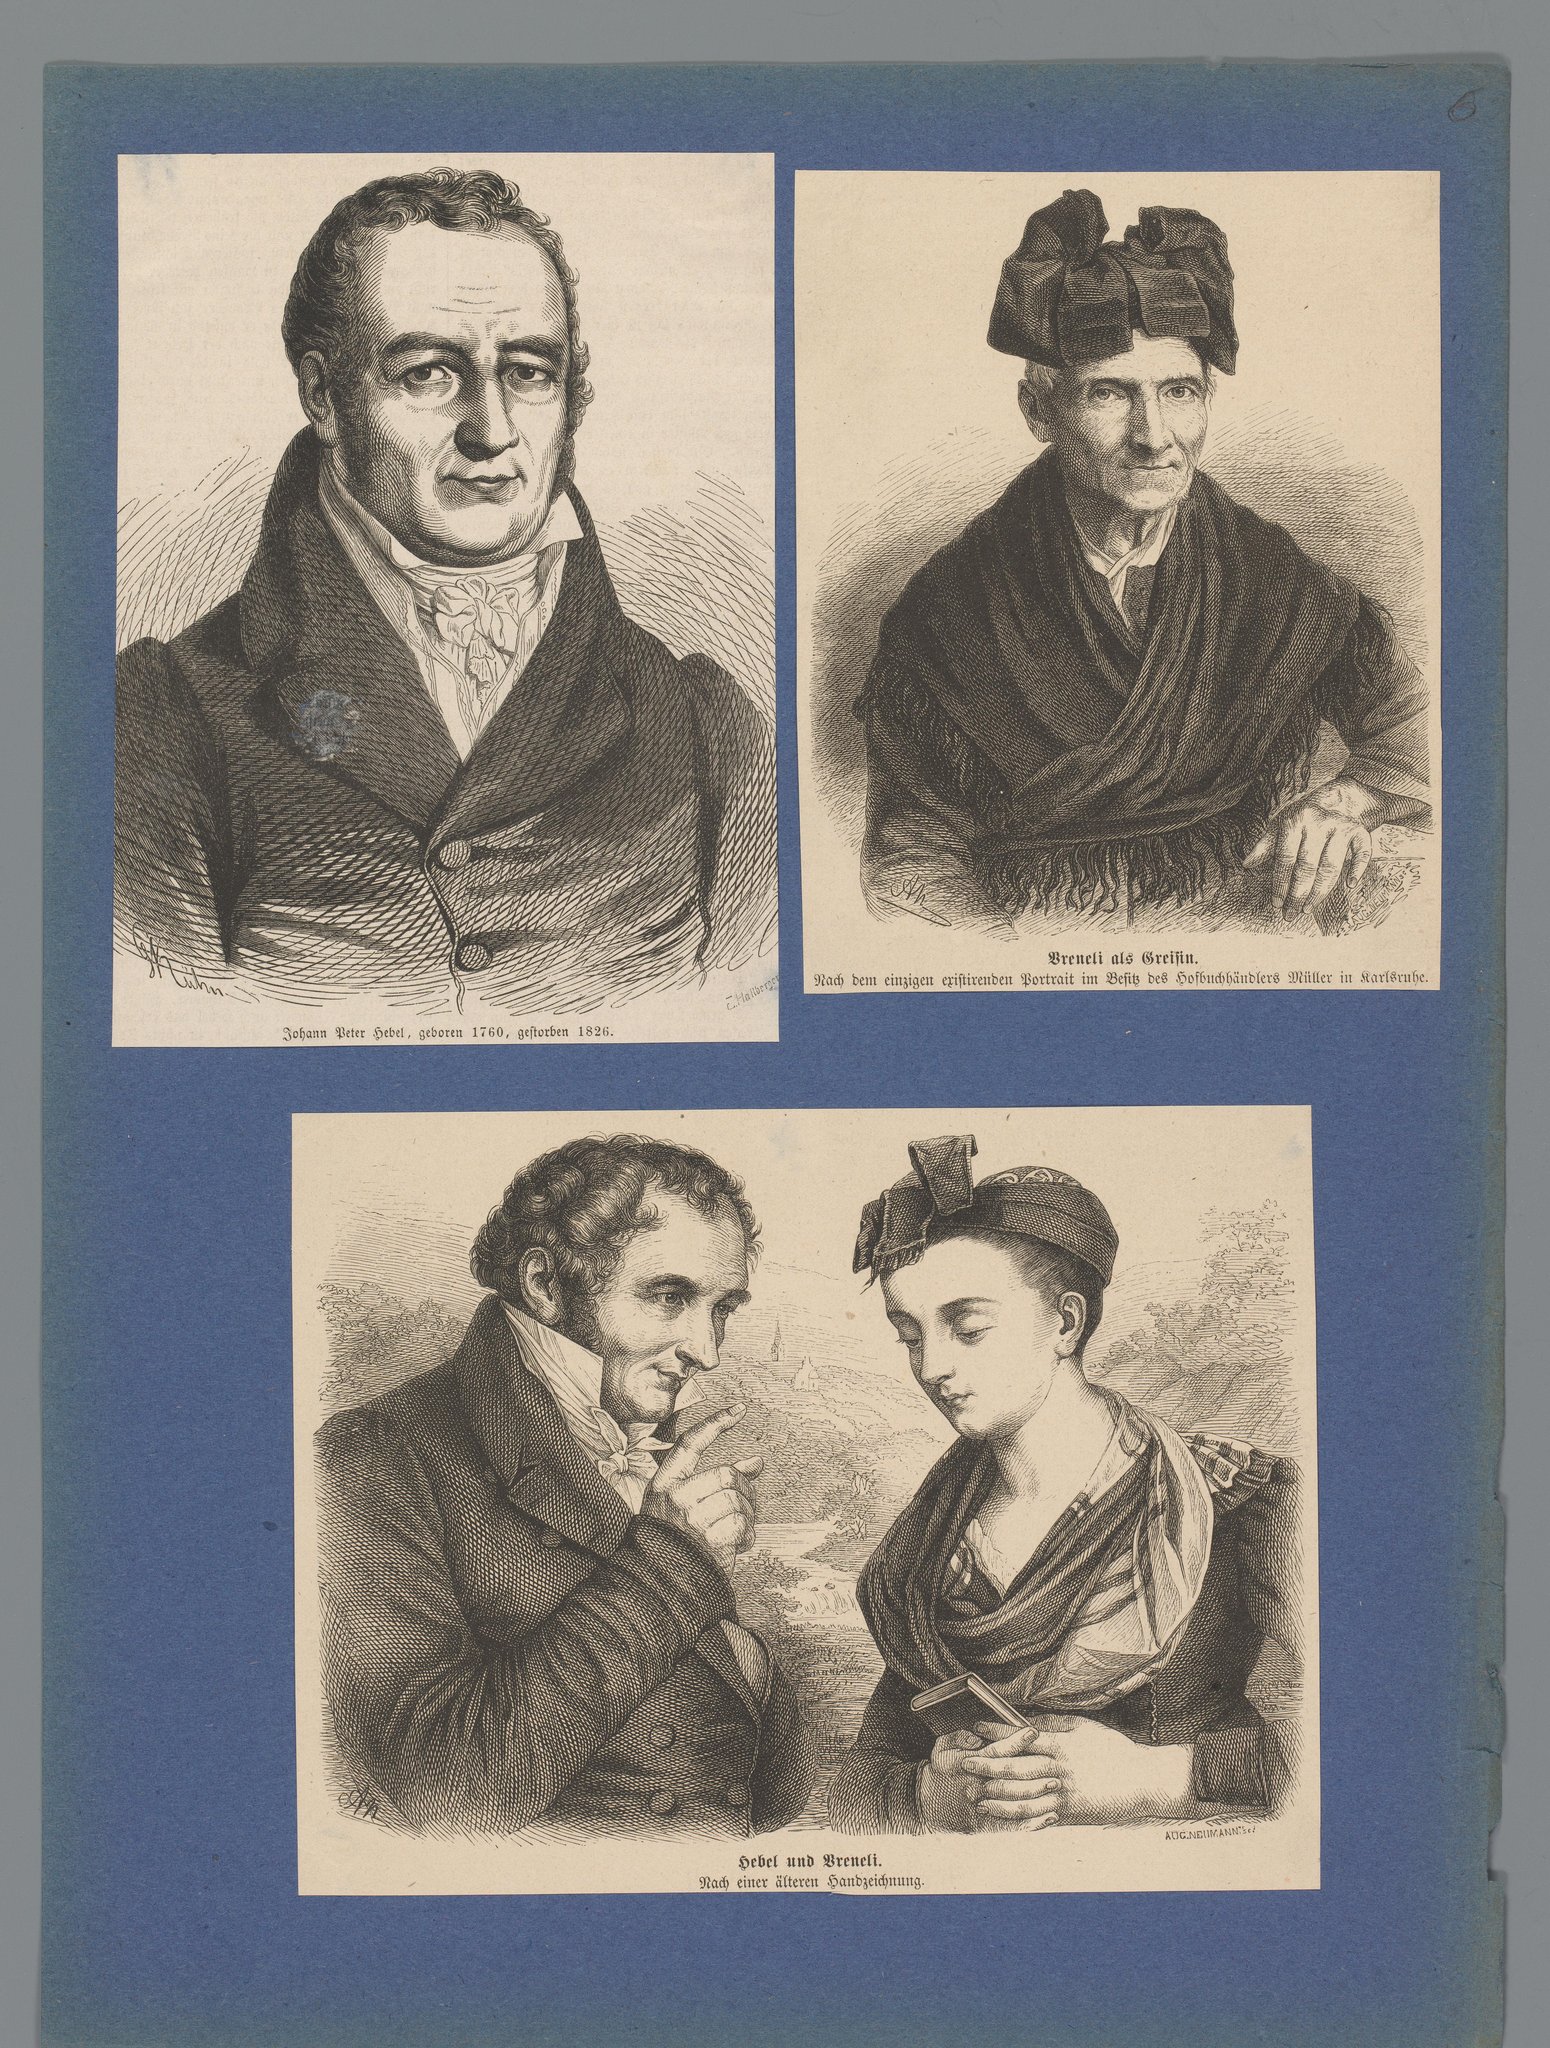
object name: sheet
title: Blad met twee portretten van Johann Peter Hebel en twee van Veronika Rohrer als 'Vreneli'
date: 1850-1900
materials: paper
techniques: letterpress printing, snipping, engraving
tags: historical persons - bb - woman, historical persons, portrait of a writer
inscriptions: number: ‘6’